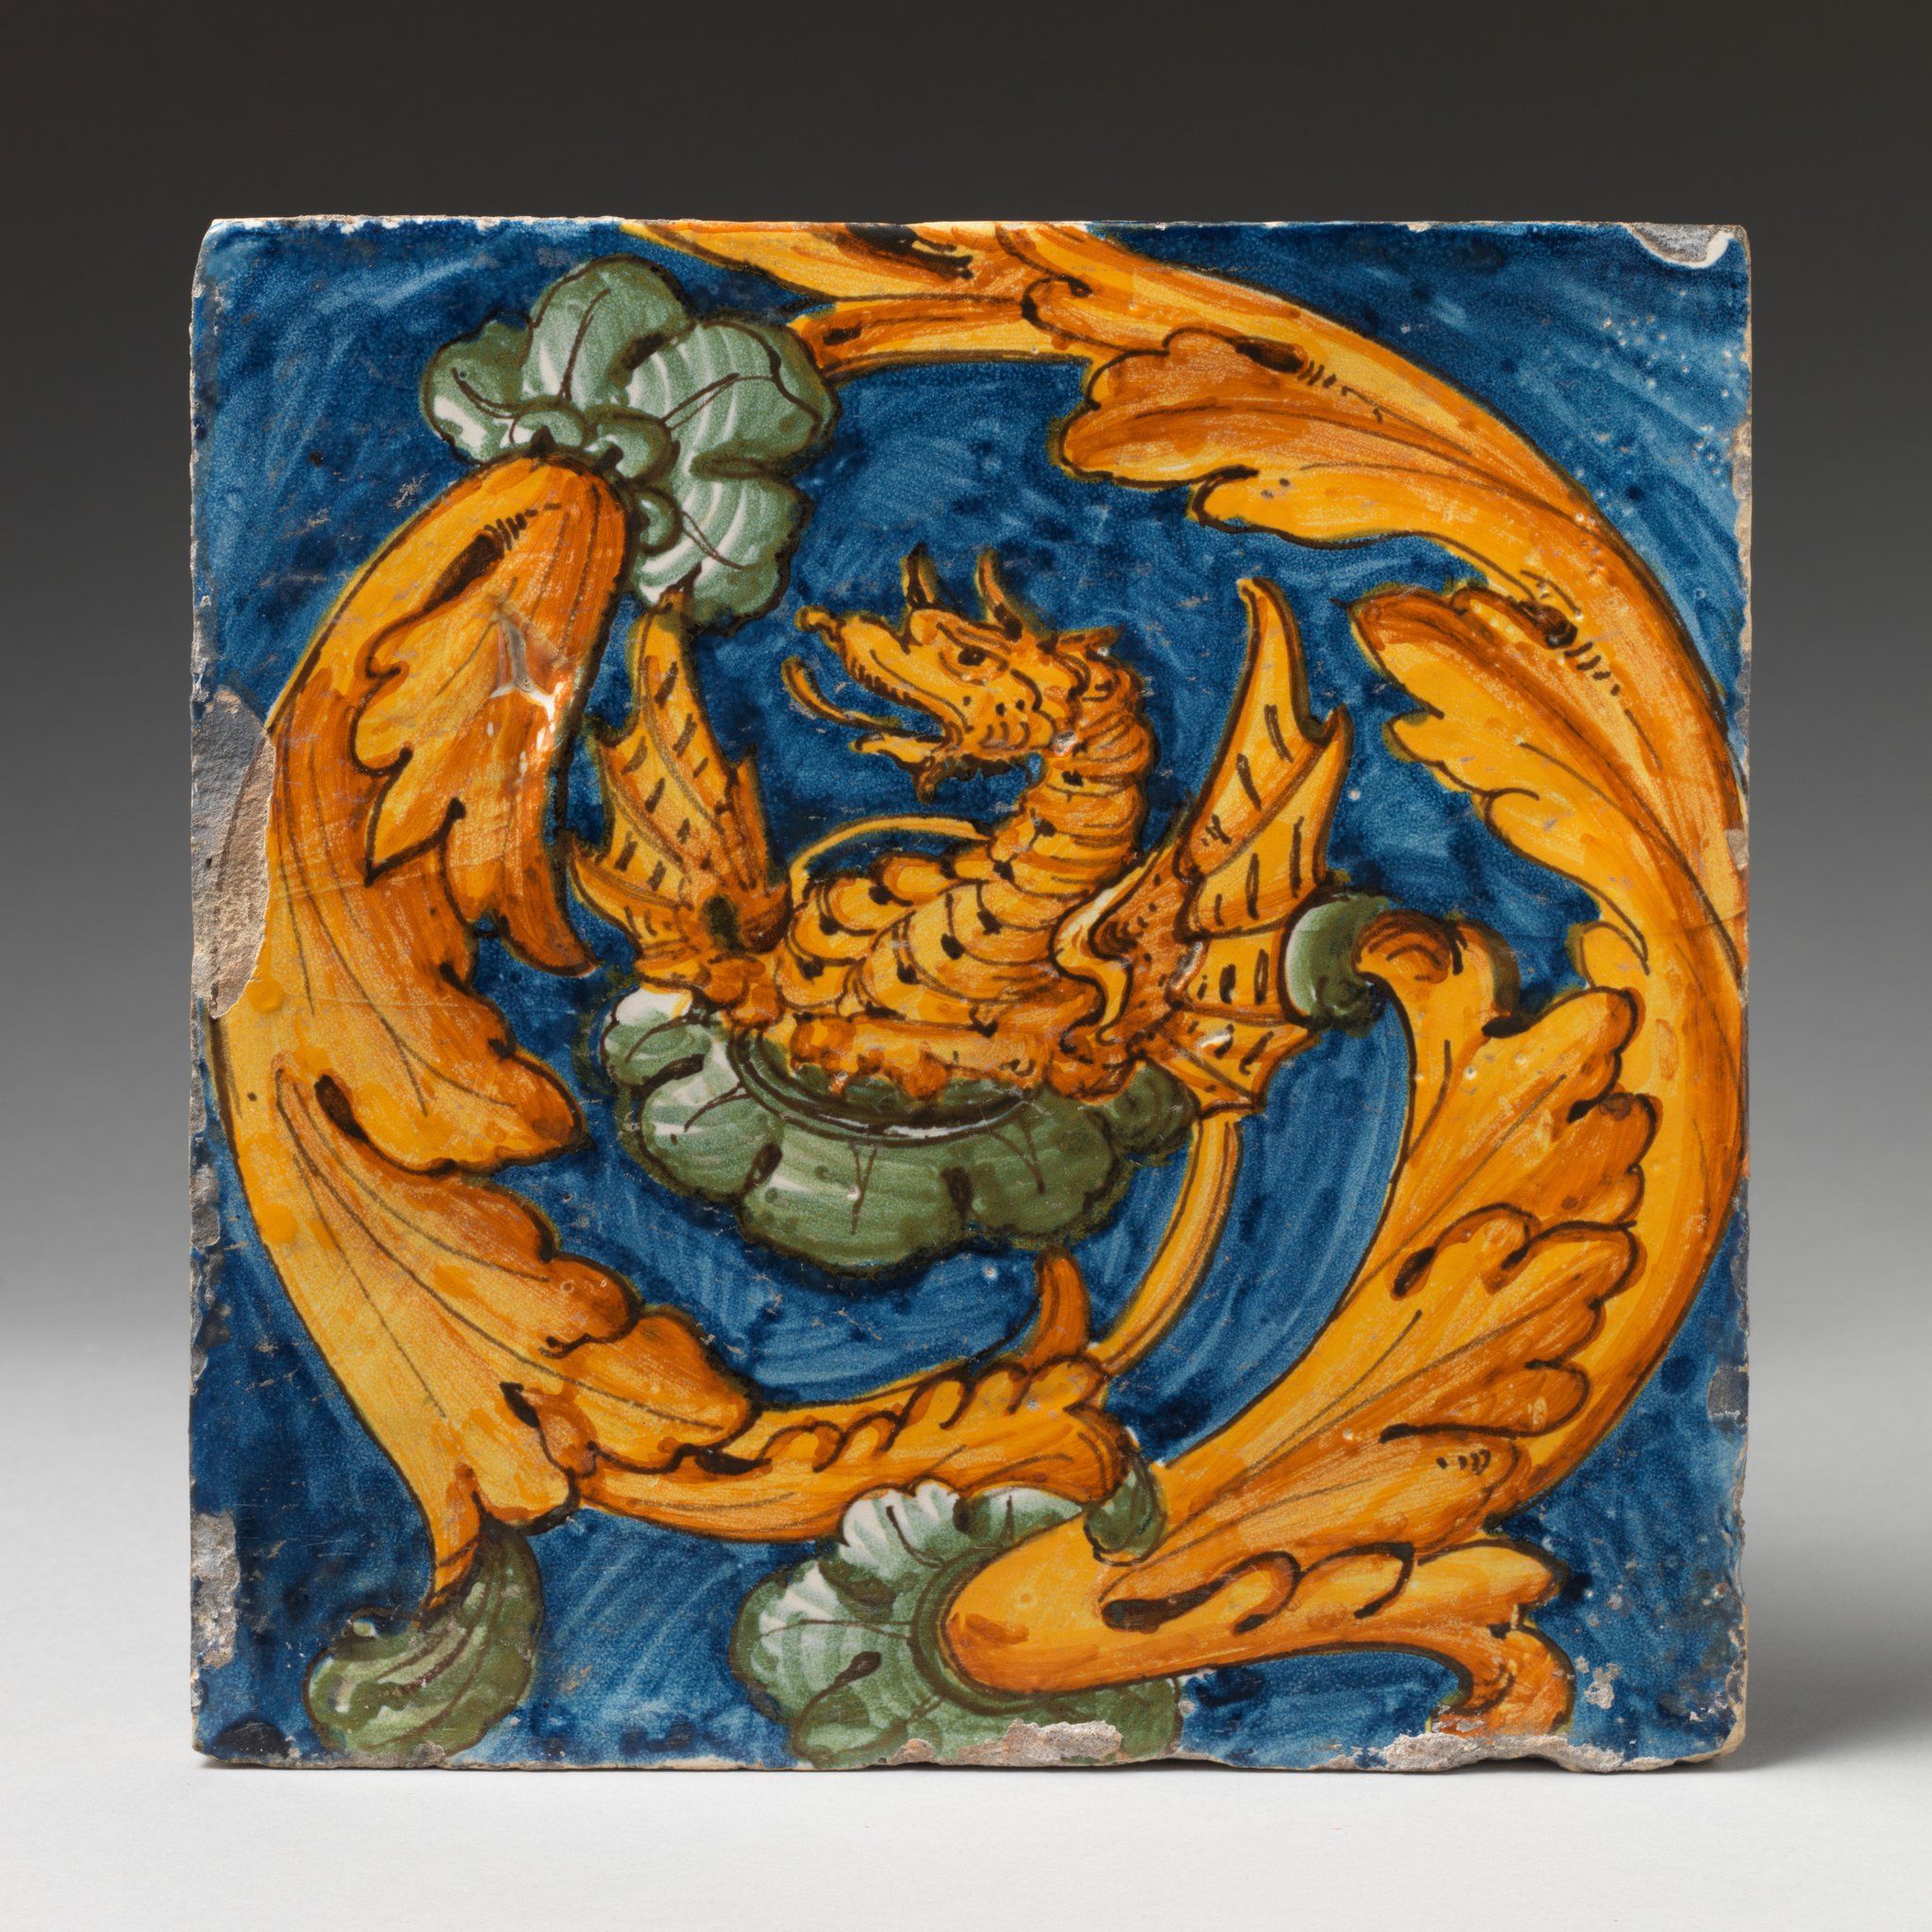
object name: tile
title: Tile with dragon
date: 1617-1627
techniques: maiolica, glazing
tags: dragons